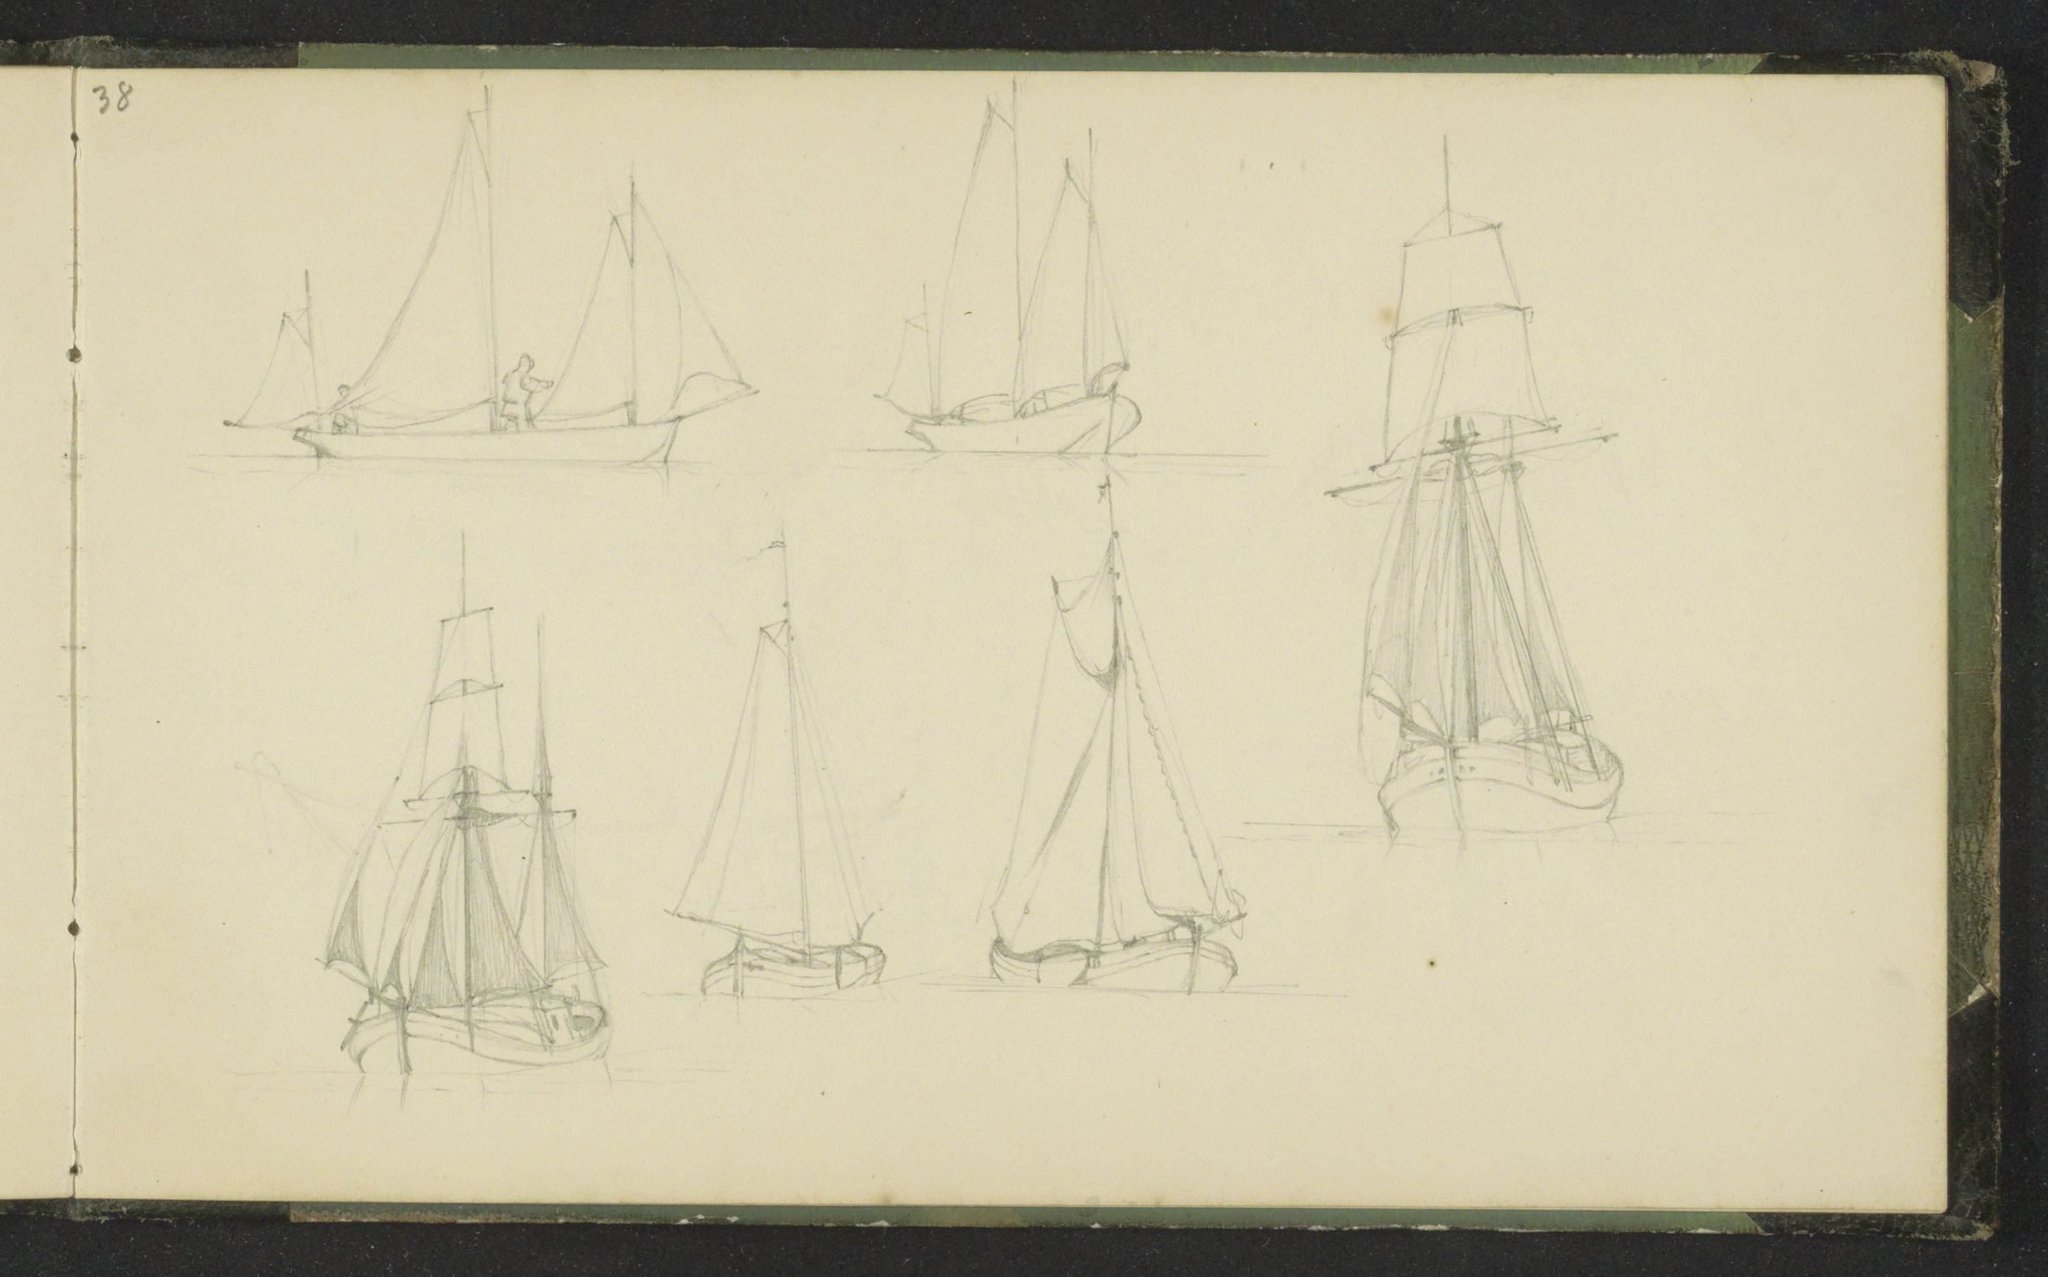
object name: sketchbook leaf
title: Studieblad met zeilschepen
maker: hendrik abraham klinkhamer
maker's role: draughtsman, painter, print maker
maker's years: 1810-1872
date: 1808-1843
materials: paper, pencil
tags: sailing-ship, sailing-boat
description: Blad 38 recto uit een schetsboek met 40 bladen.